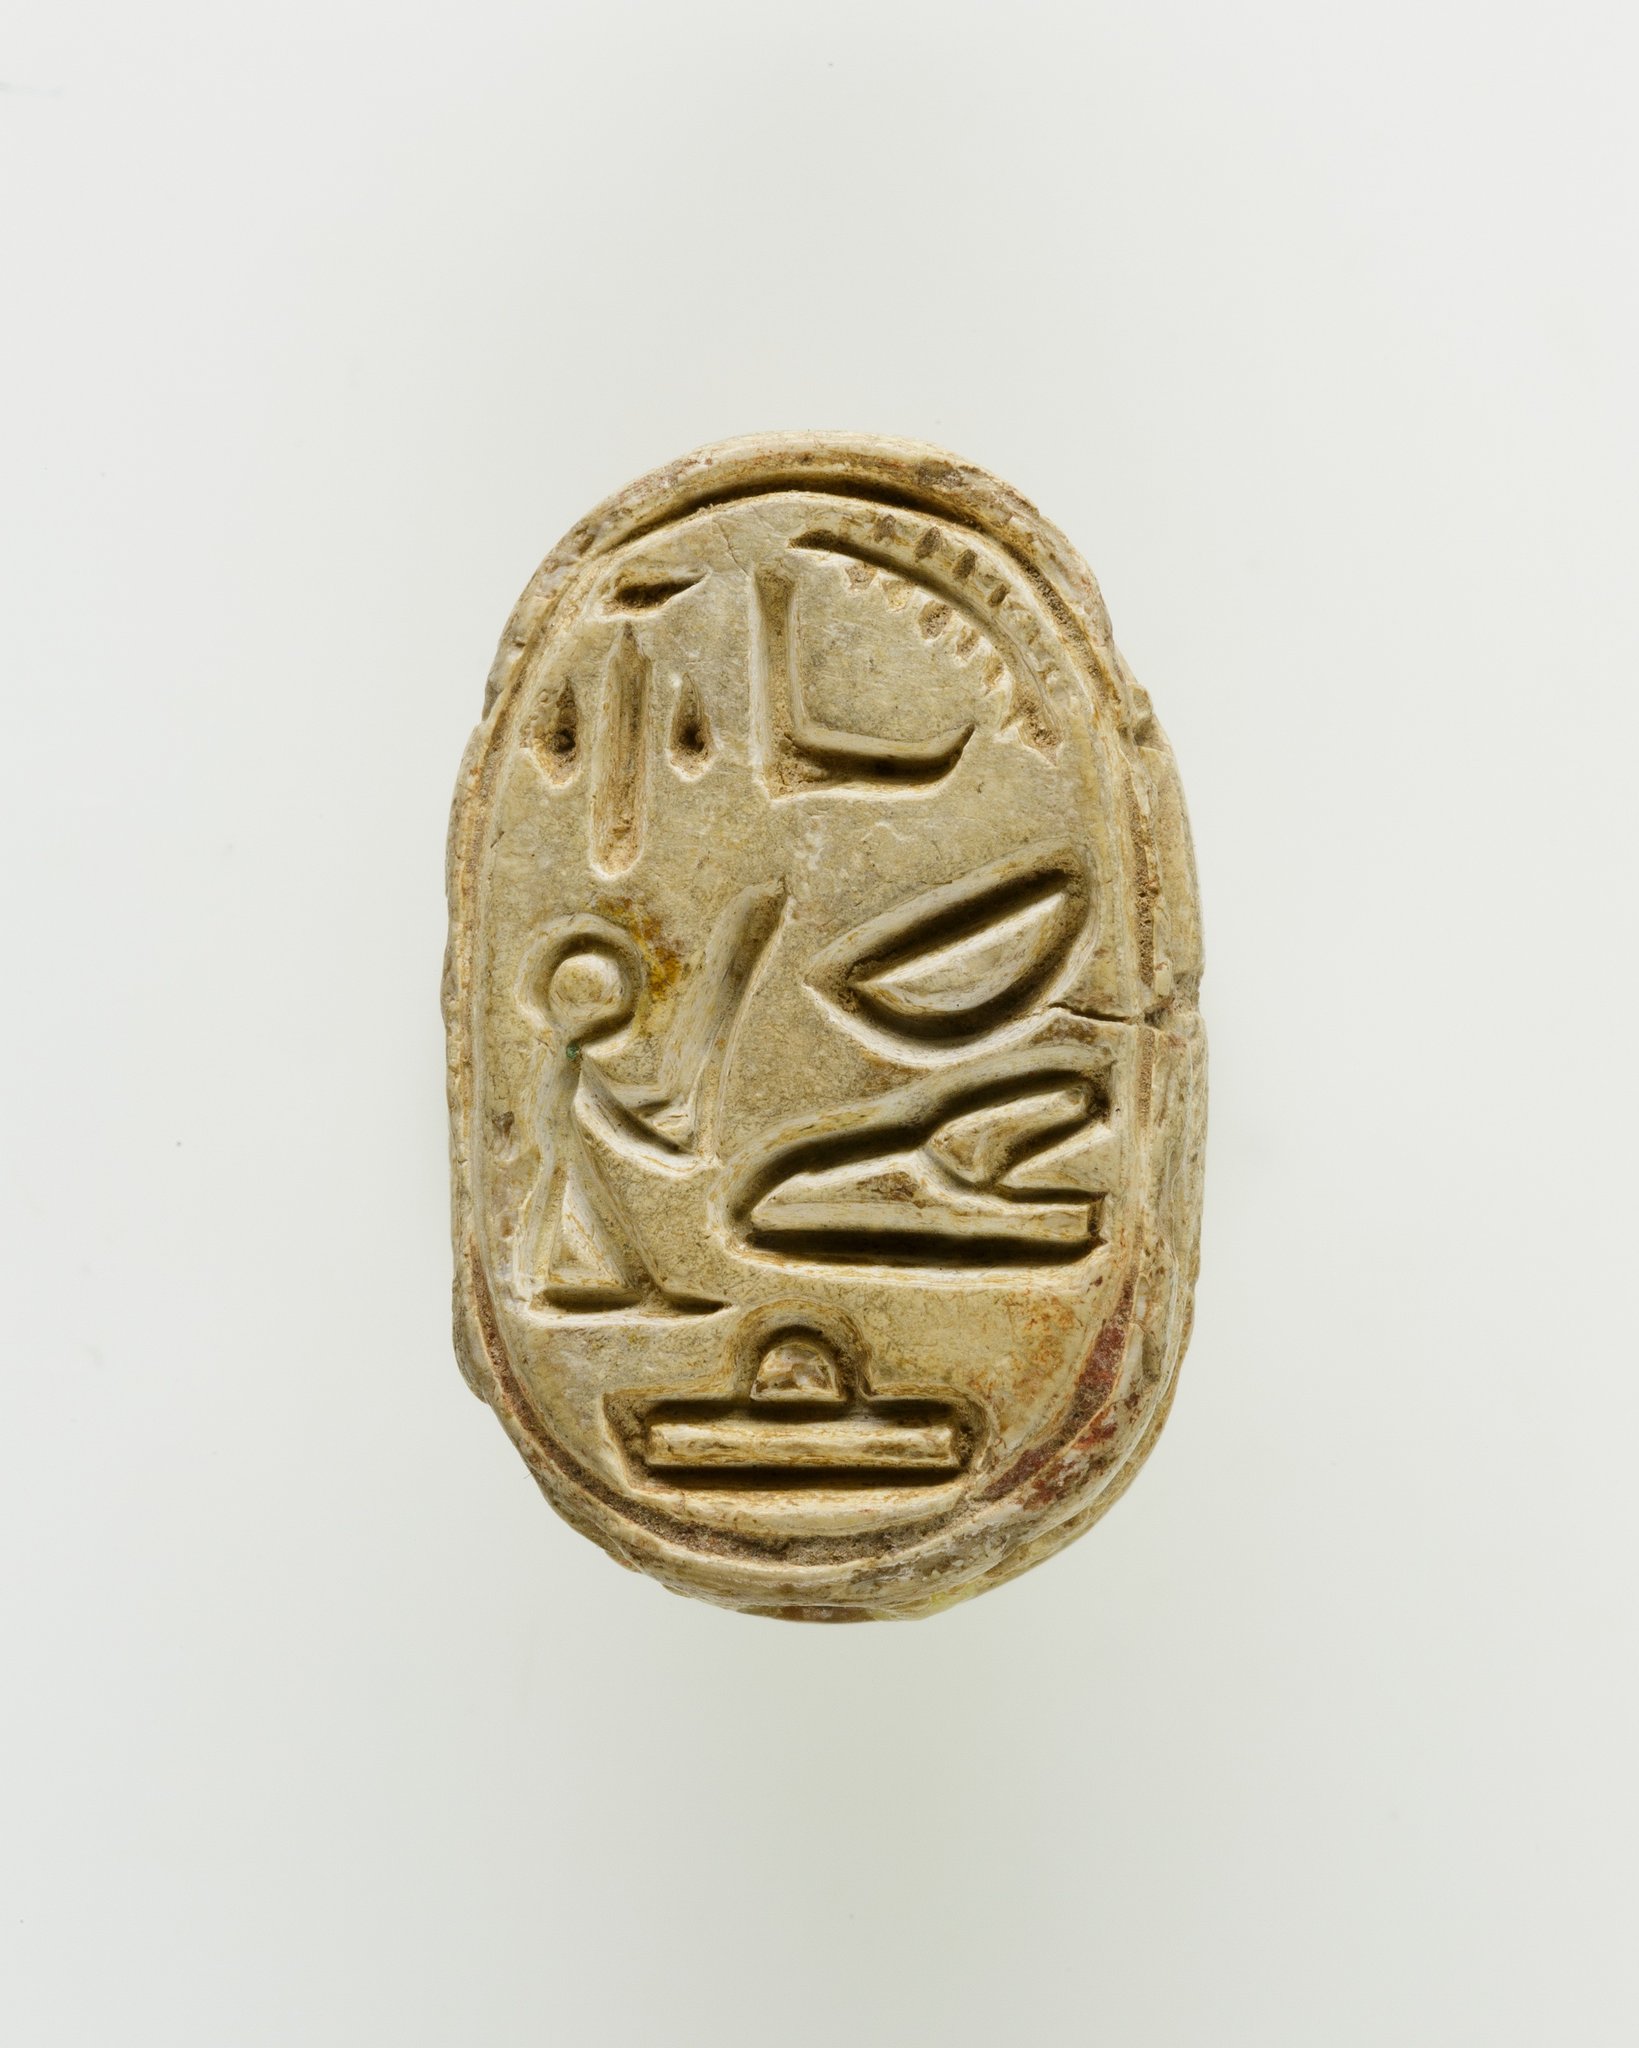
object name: scarab, official, private name and title, wab priest, sebekhotepnakht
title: Scarab of a Priest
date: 1760-1670 BCE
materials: stone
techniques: glazing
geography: egypt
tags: hieroglyphs,scarabs